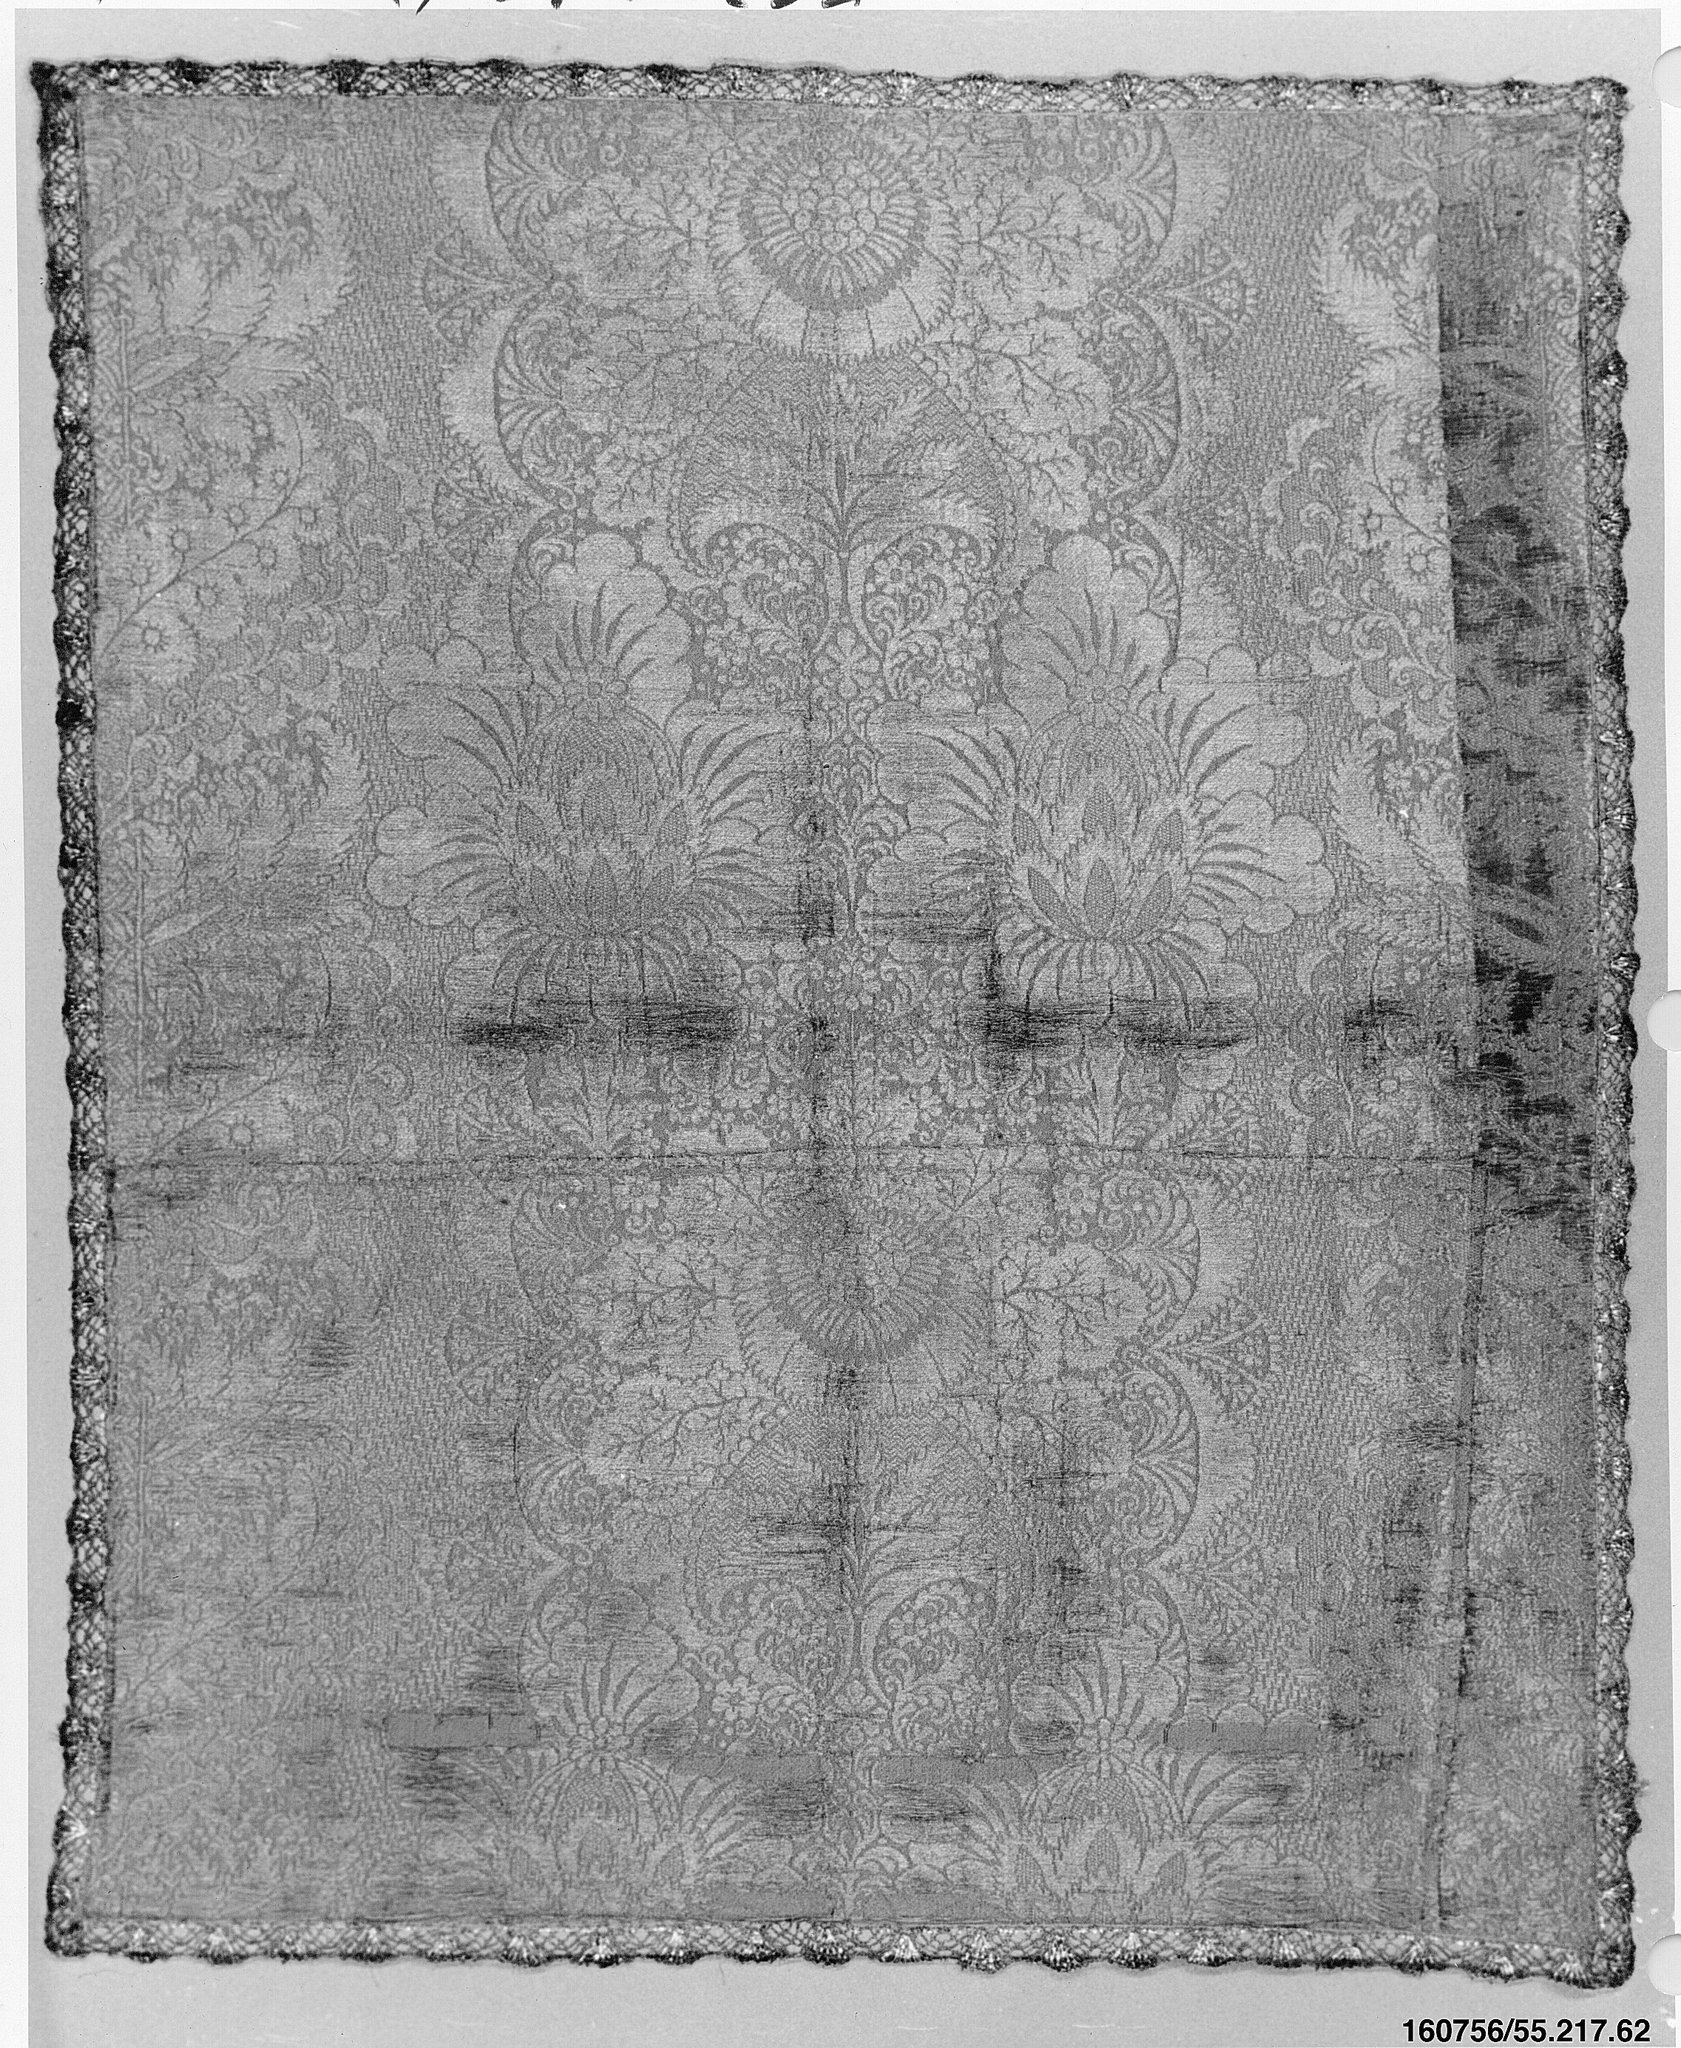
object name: piece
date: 1720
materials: metal thread, silk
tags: flowers,leaves